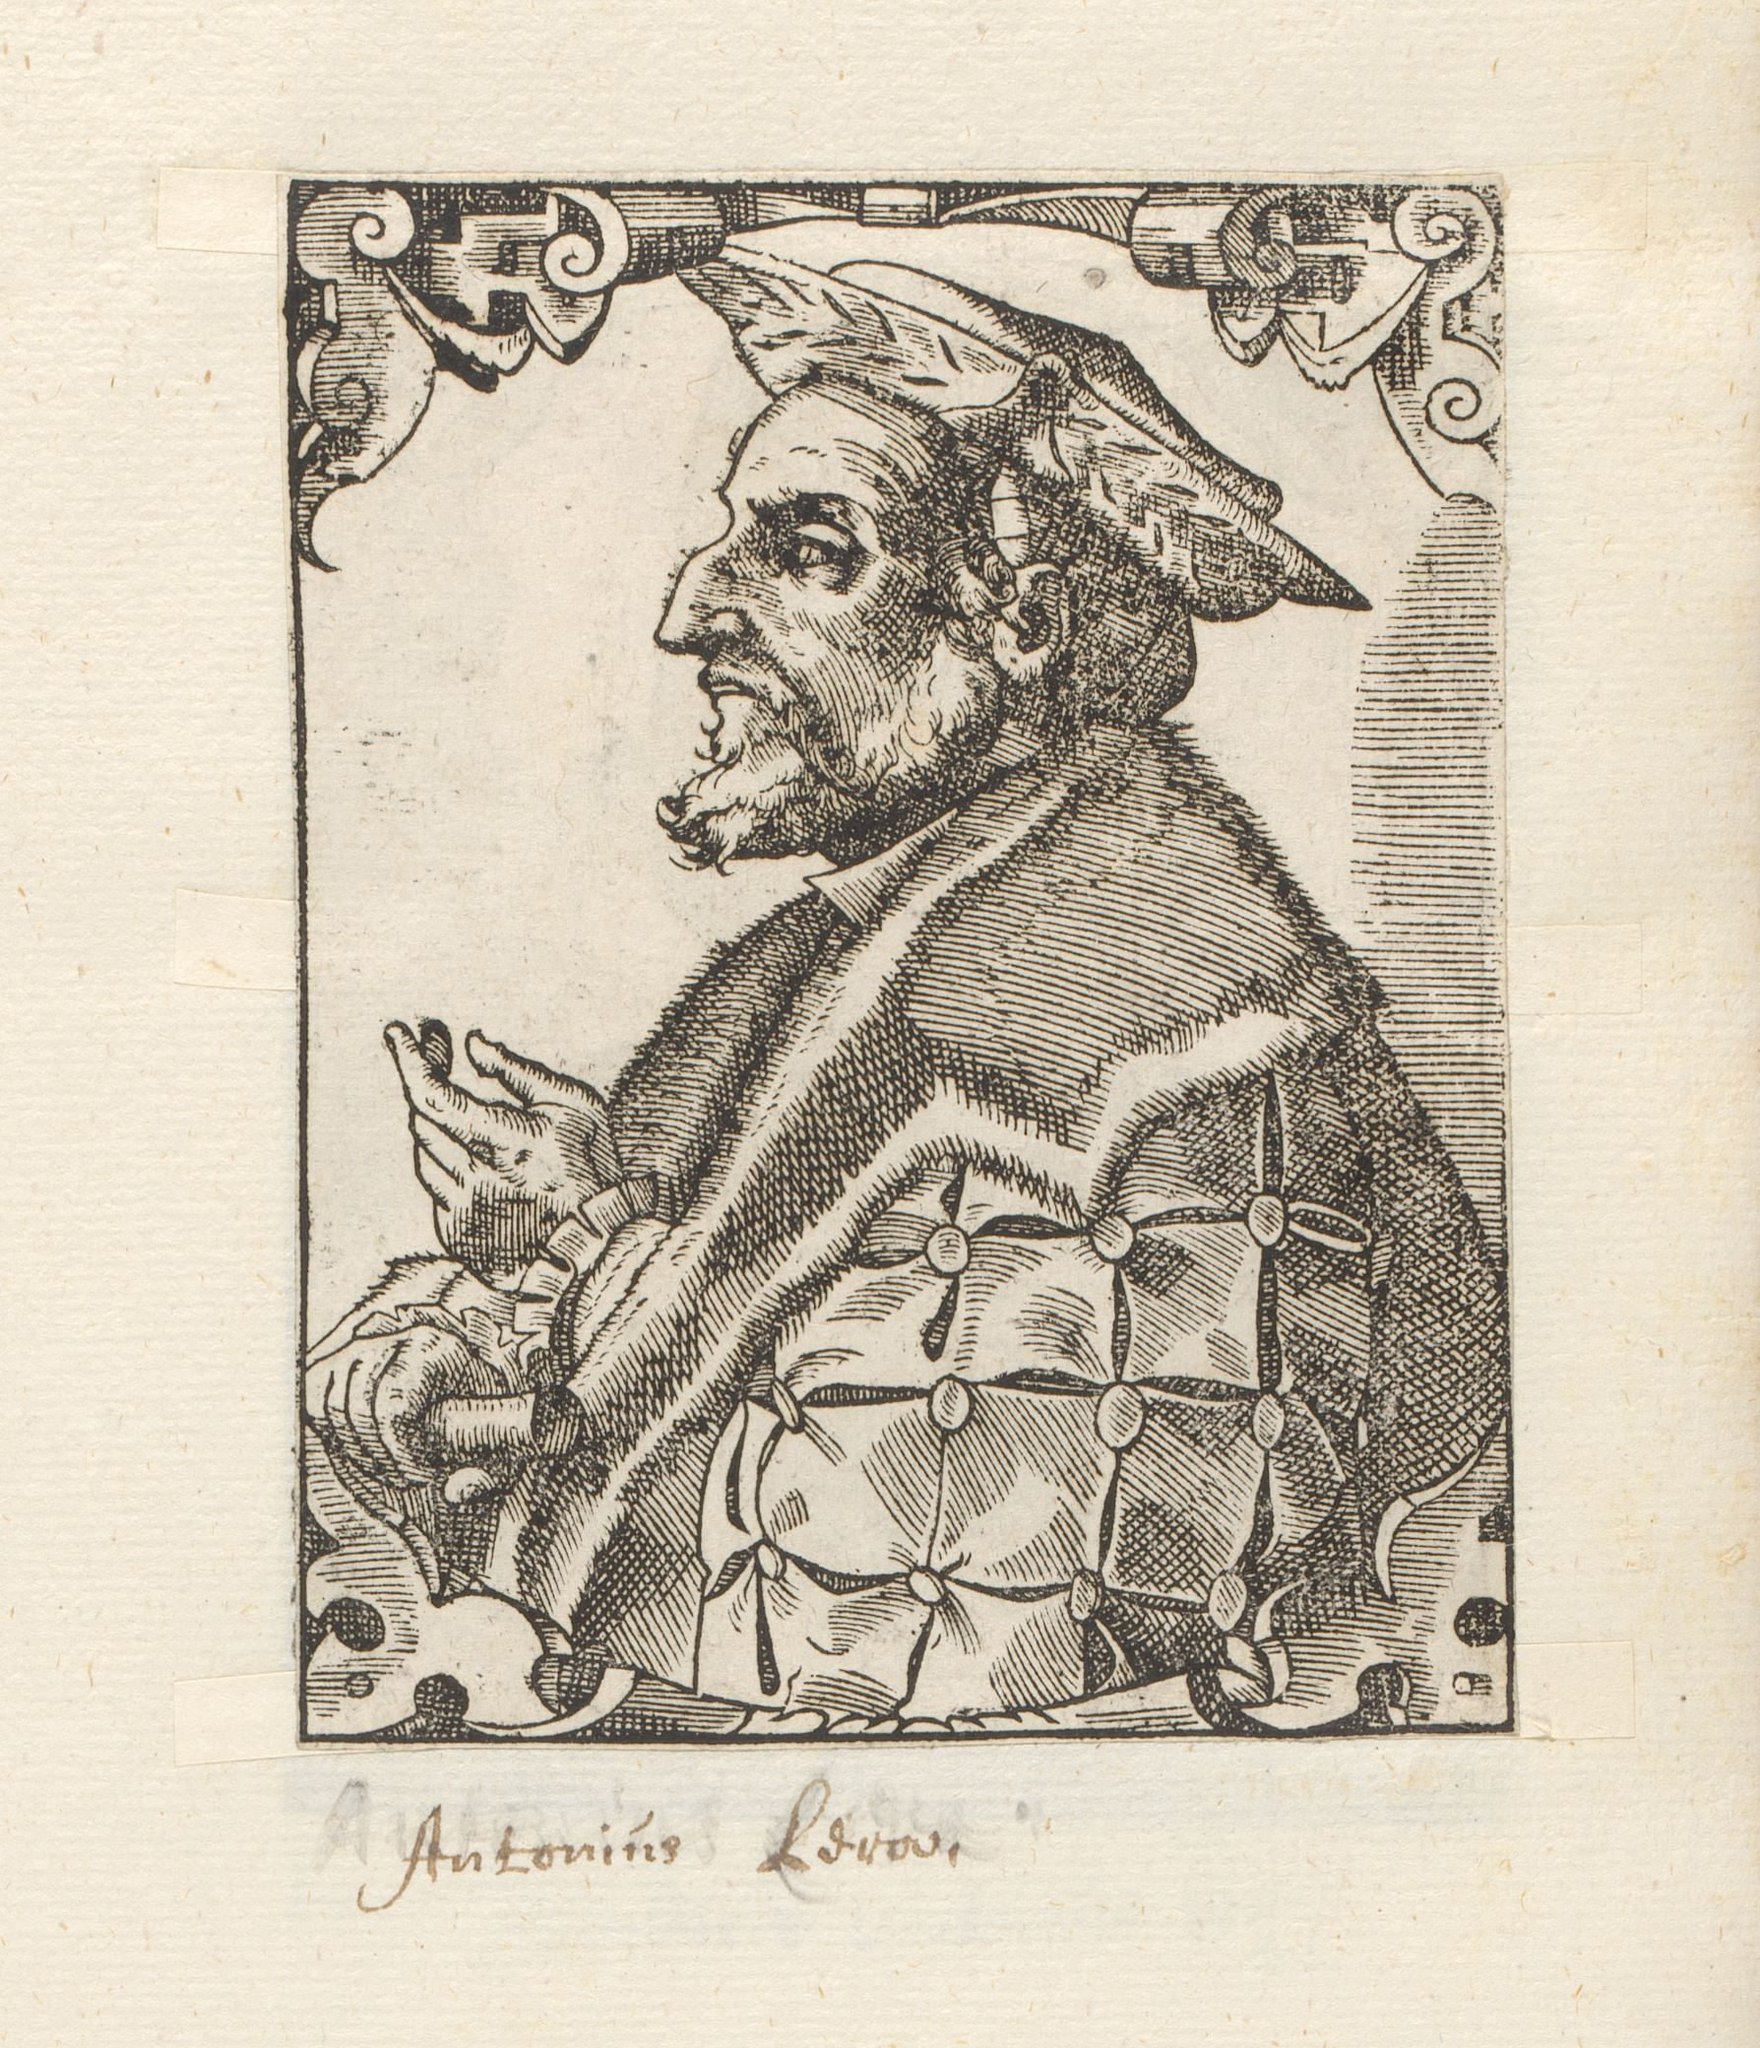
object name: album leaf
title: Portret van Antonio de Leyva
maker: Anonymous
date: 1549-1575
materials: paper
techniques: woodcut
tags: commander-in-chief, general, marshal, historical persons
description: Prent gebruikt in: Giovio, Paolo. Elogia Virorum bellica virtute illustrium (...). Bazel: Peter Perna, 1575.